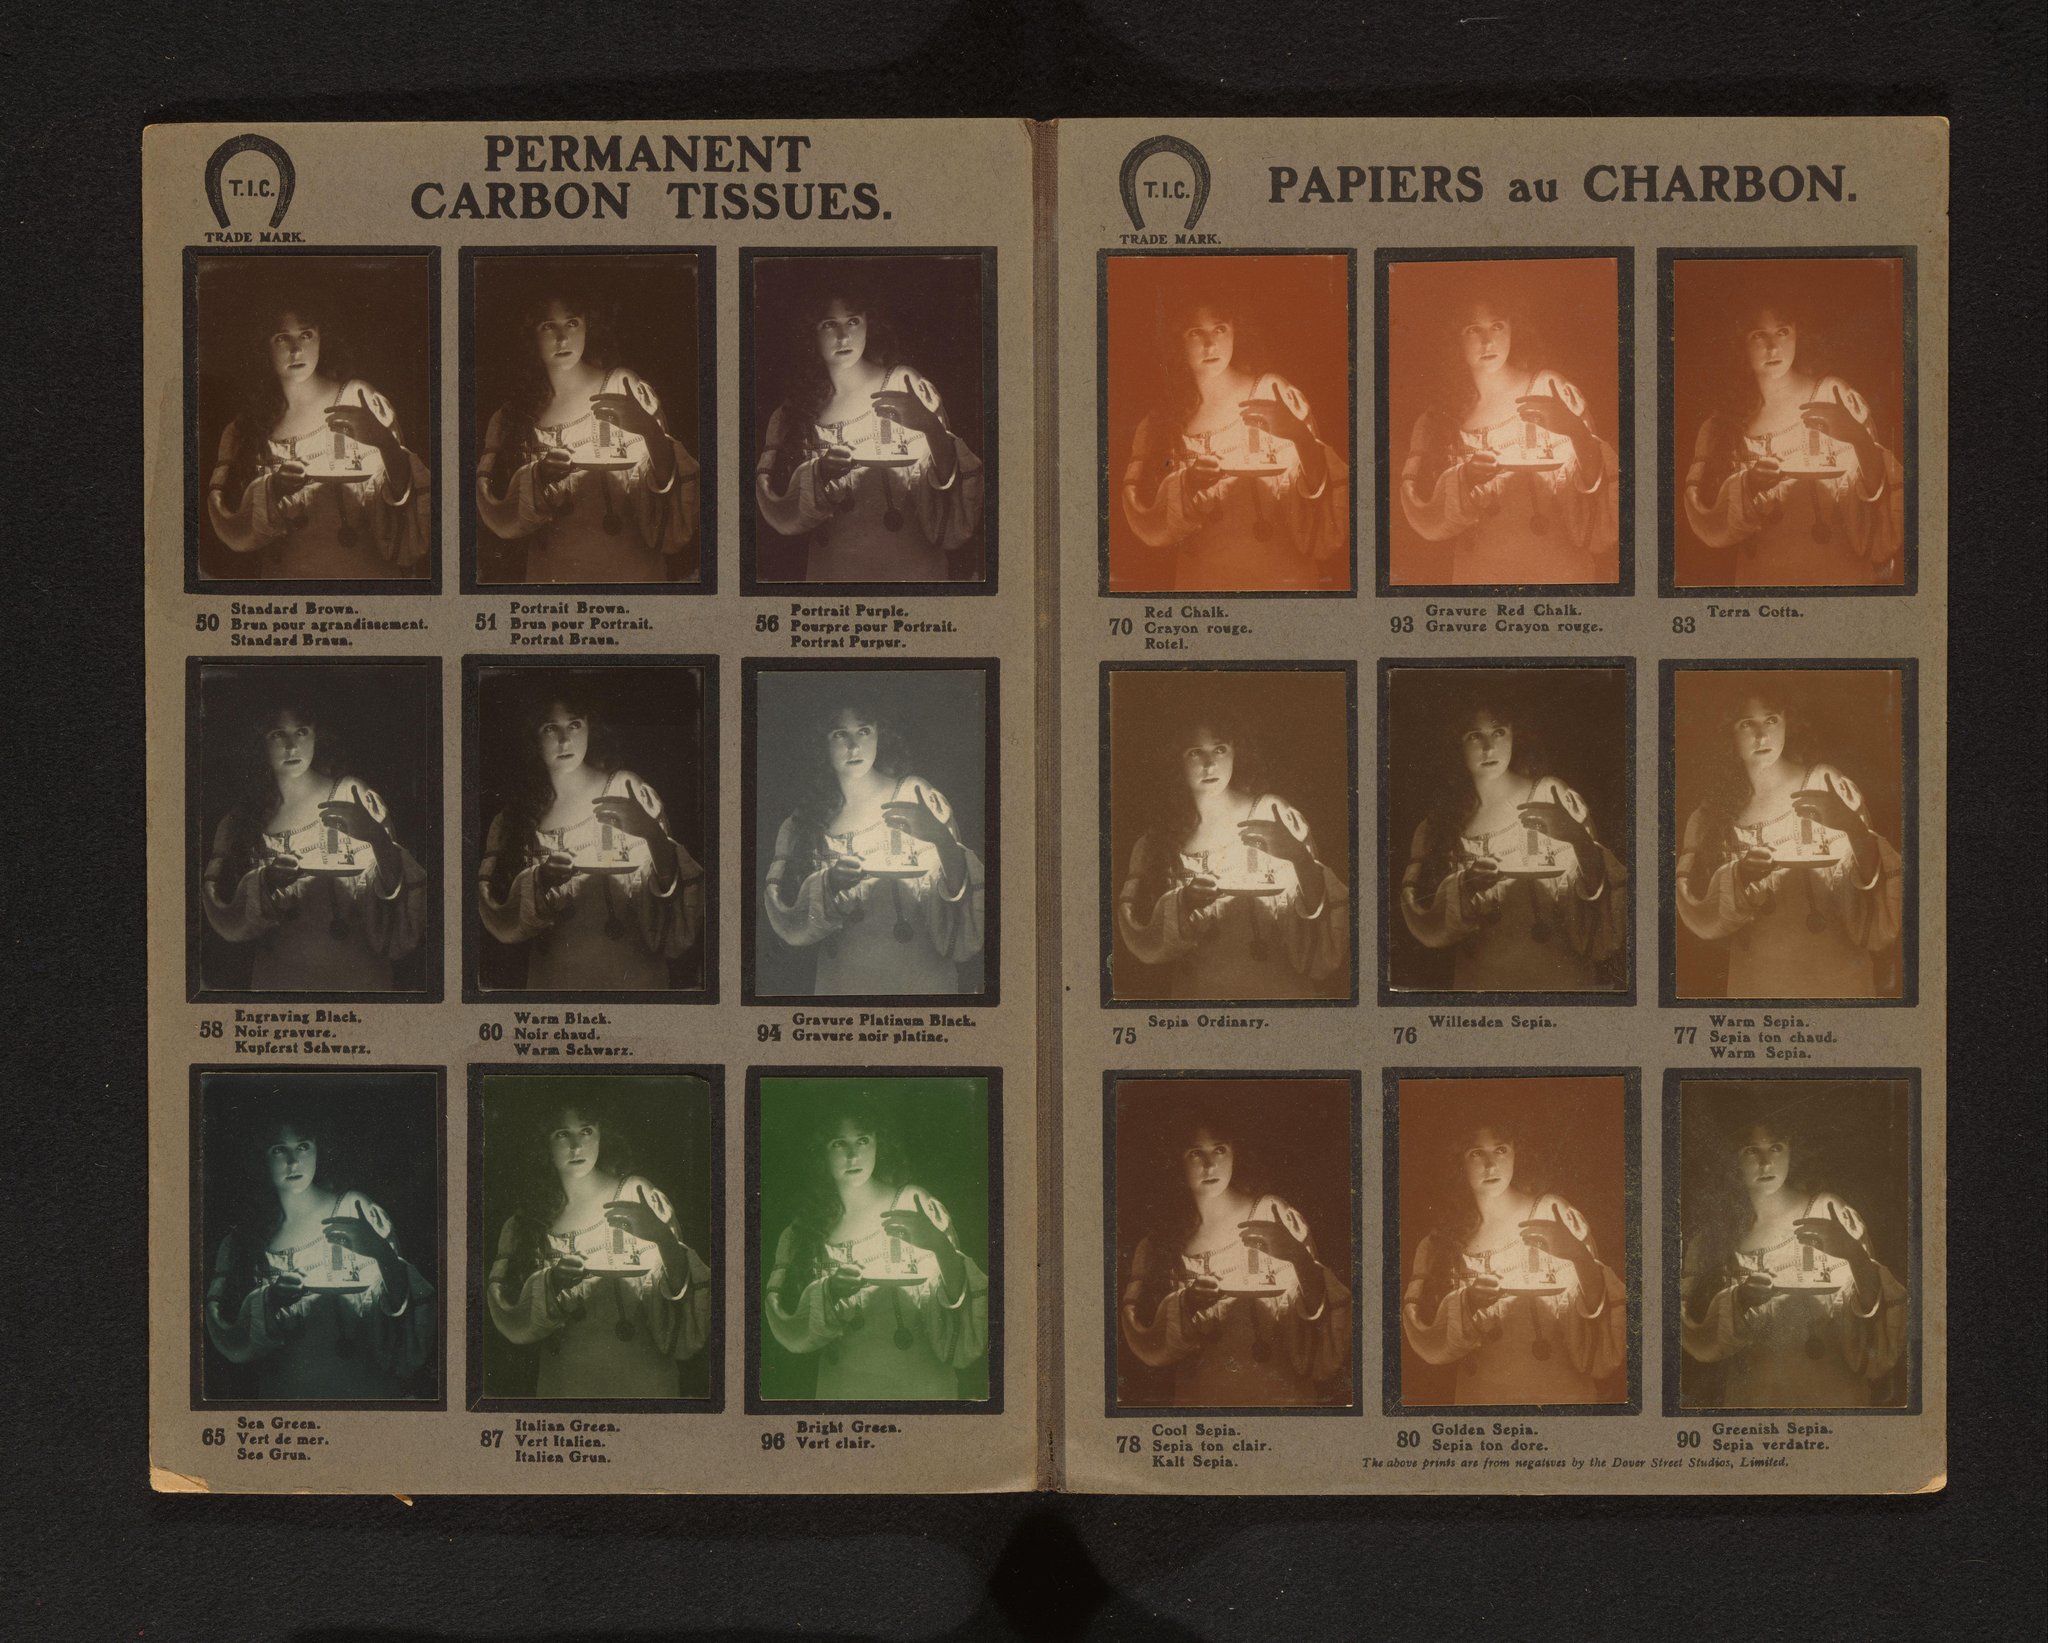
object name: photograph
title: Negen portretten van een onbekende vrouw met een kaars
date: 1910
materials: cardboard, photographic support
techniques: carbon print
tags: adult woman, candle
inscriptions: inscription: ‘50 Standard Brown. 51 Portrait Brown. 56. Portrait Purple. 58. Engraving Black. 60. Warm Black. 94. Gravure Platinum Black. 65. Sea Green. 87. Italian Green. 96. Bright Green.’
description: Voorbeeldkaart met 9 verschillend getoonde kooldrukken.